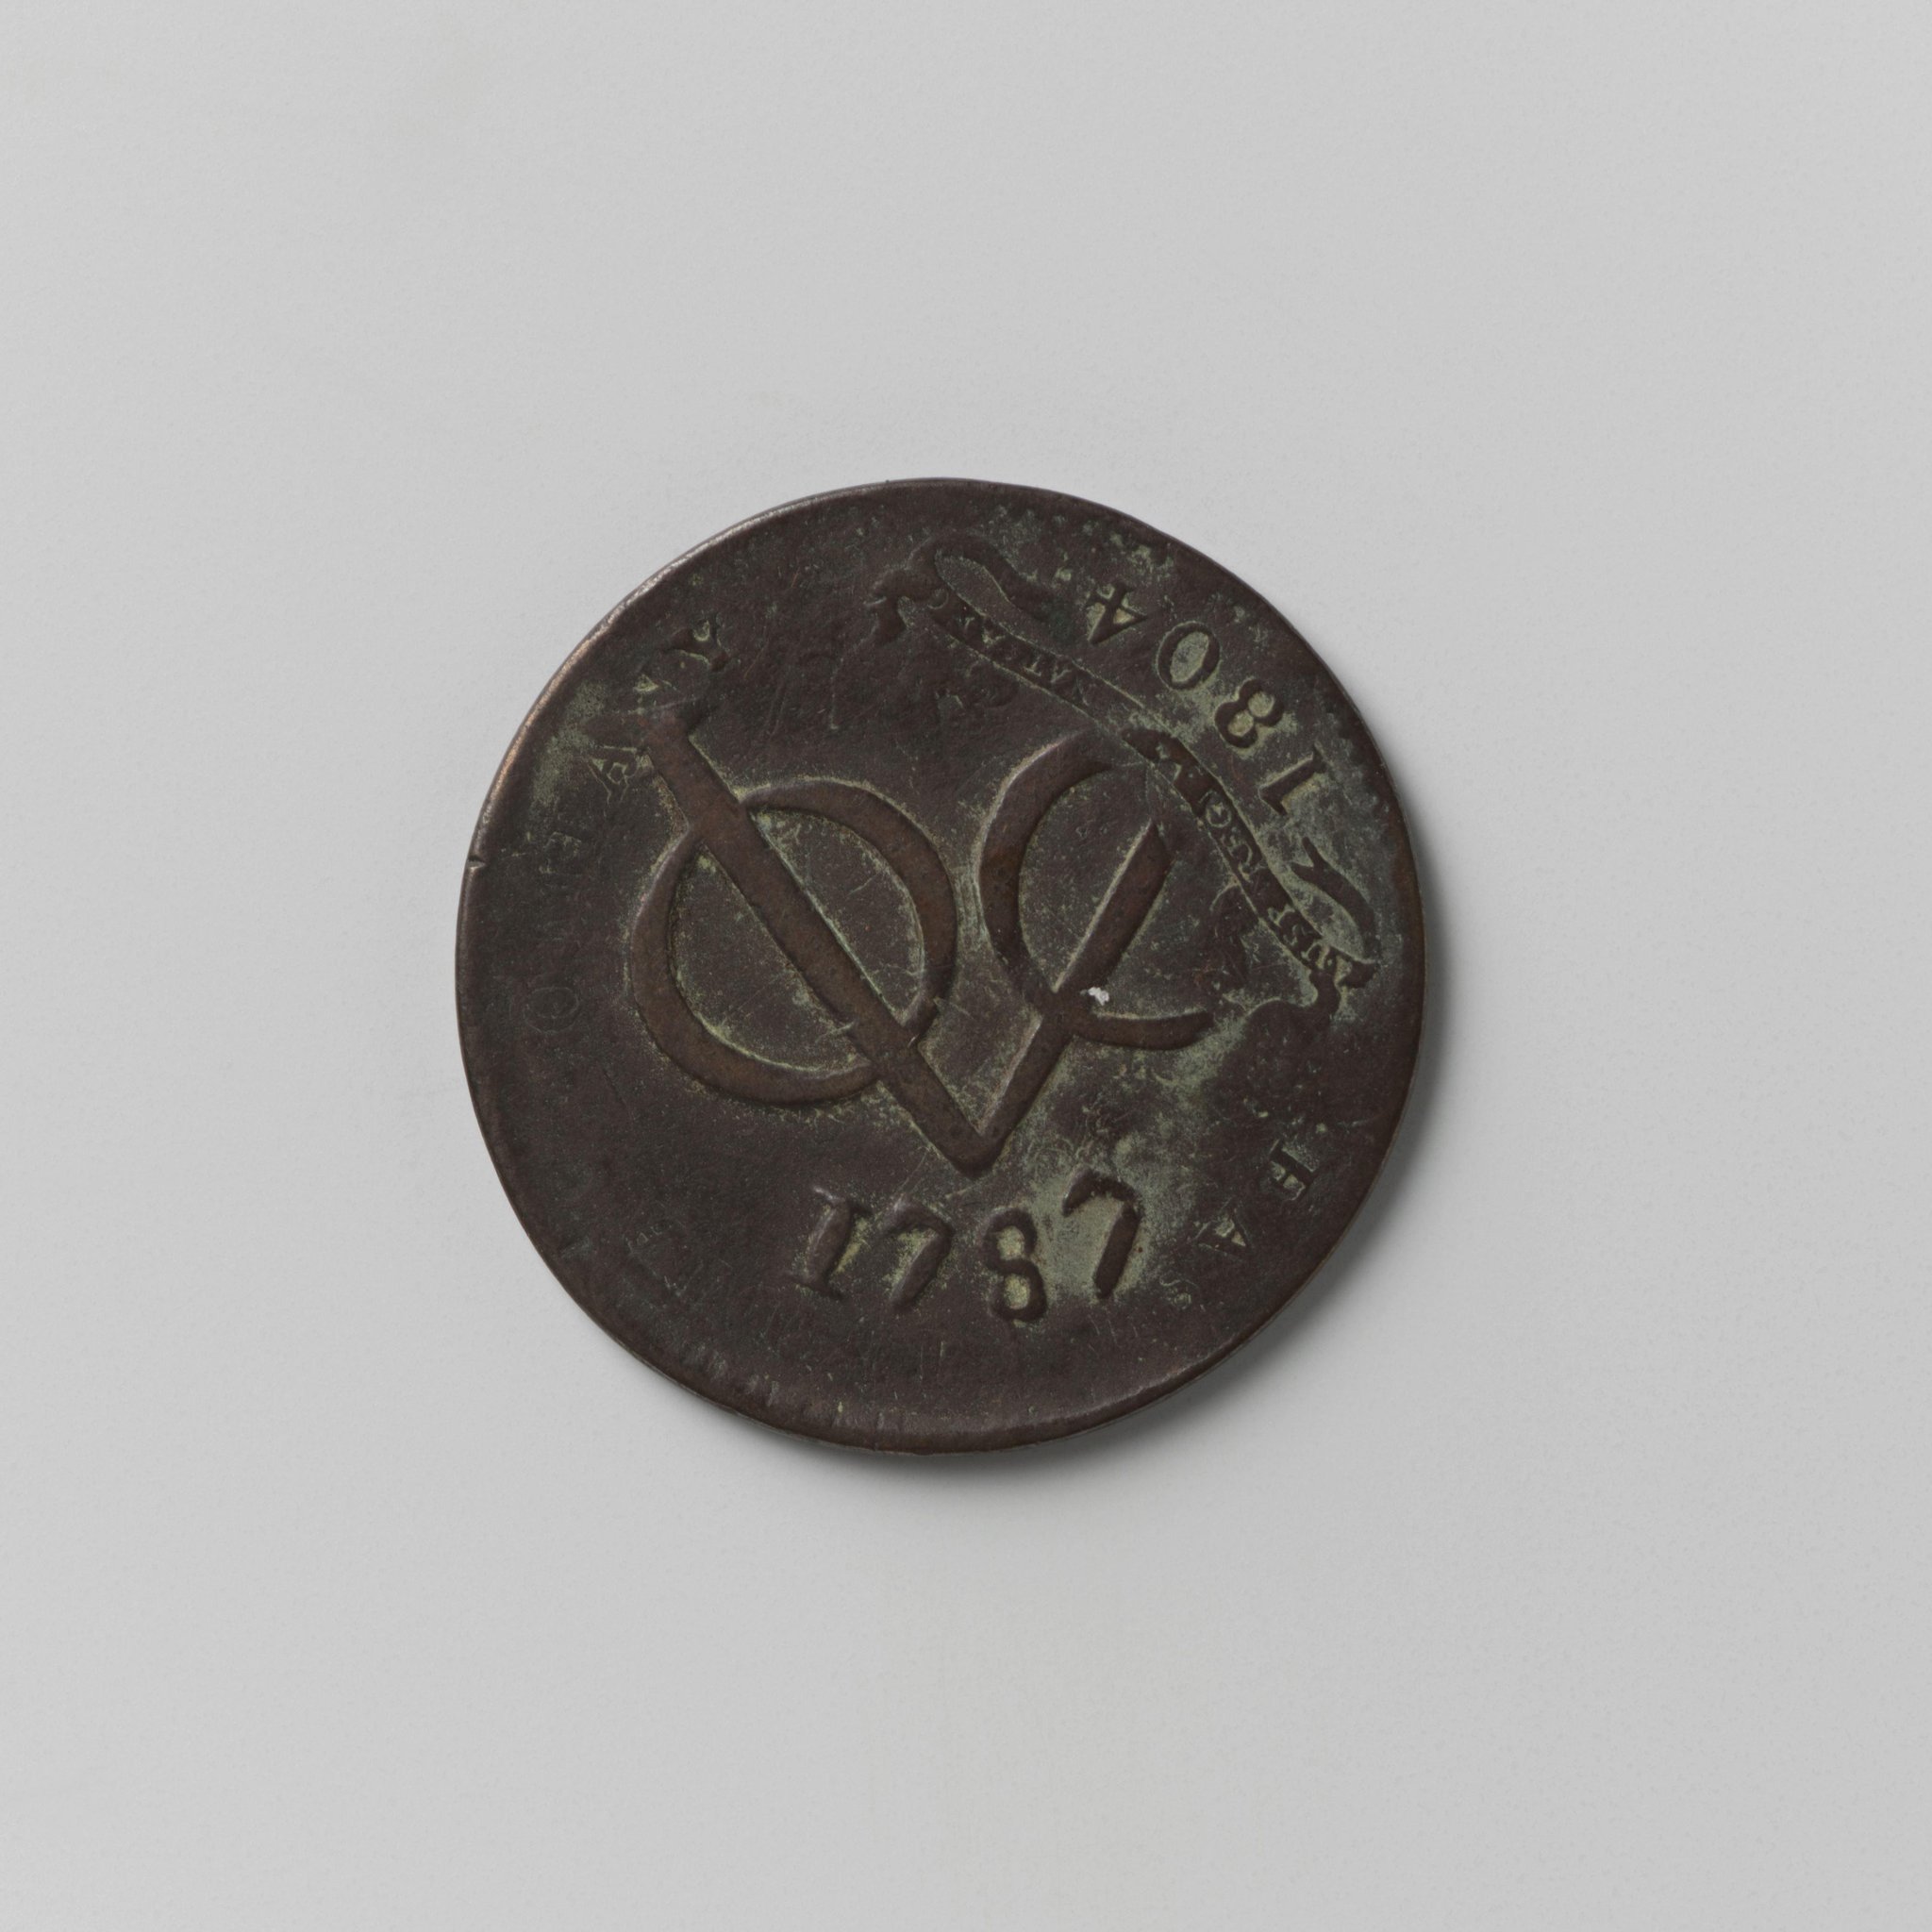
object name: coin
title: Nabootsing van een duit van de VOC uit West-Friesland, 1787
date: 1787-1830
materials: copper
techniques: striking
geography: banjarmasin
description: Koperen munt. Nabootsing van duit van de VOC uit West-Friesland. Voorzijde: gekroond wapenschild van West-Friesland. Keerzijde: monogram van de VOC, waaronder fictief jaartal. Geslagen op muntplaatje van 1/2 paisa uit Bombay.